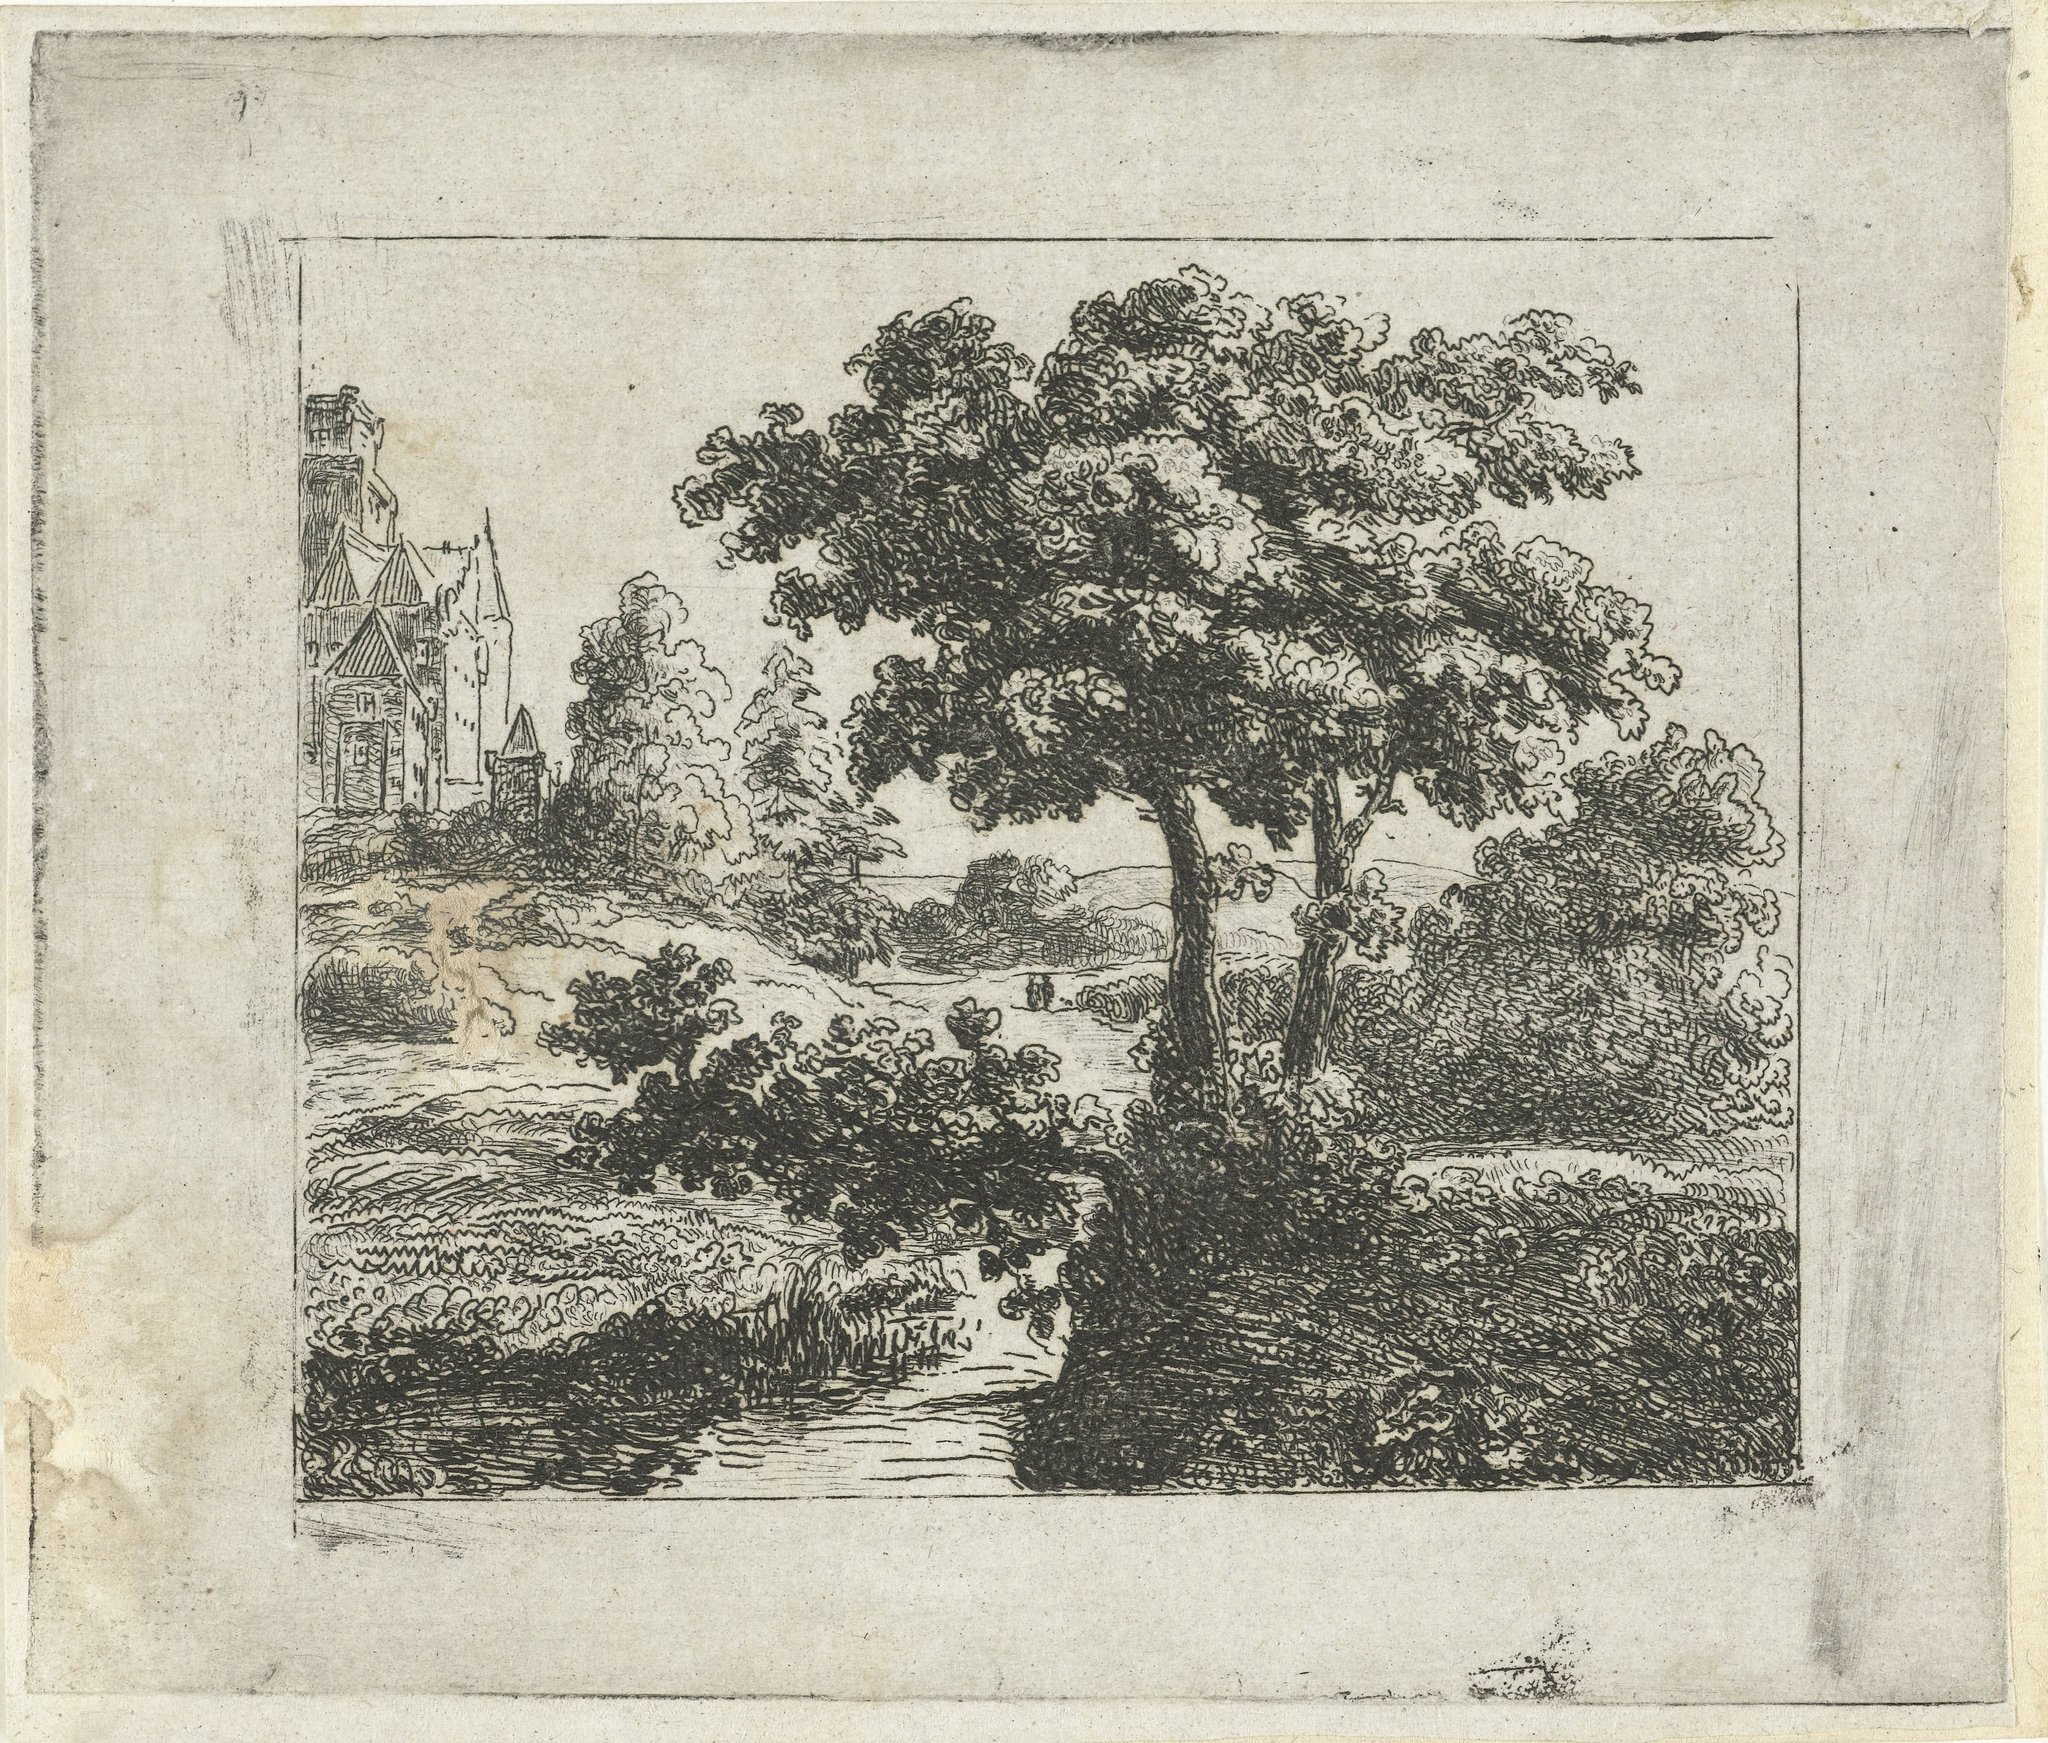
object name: print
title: Landschap met kerk op een heuvel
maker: johannes adrianus van der drift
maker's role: print maker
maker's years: 1808-1883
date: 1823-1883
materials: paper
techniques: etching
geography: netherlands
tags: landscape with other man-made constructions not mentioned above, e.g.: graveyards, playgrounds, etc.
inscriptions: collector's mark: Lugt 2228